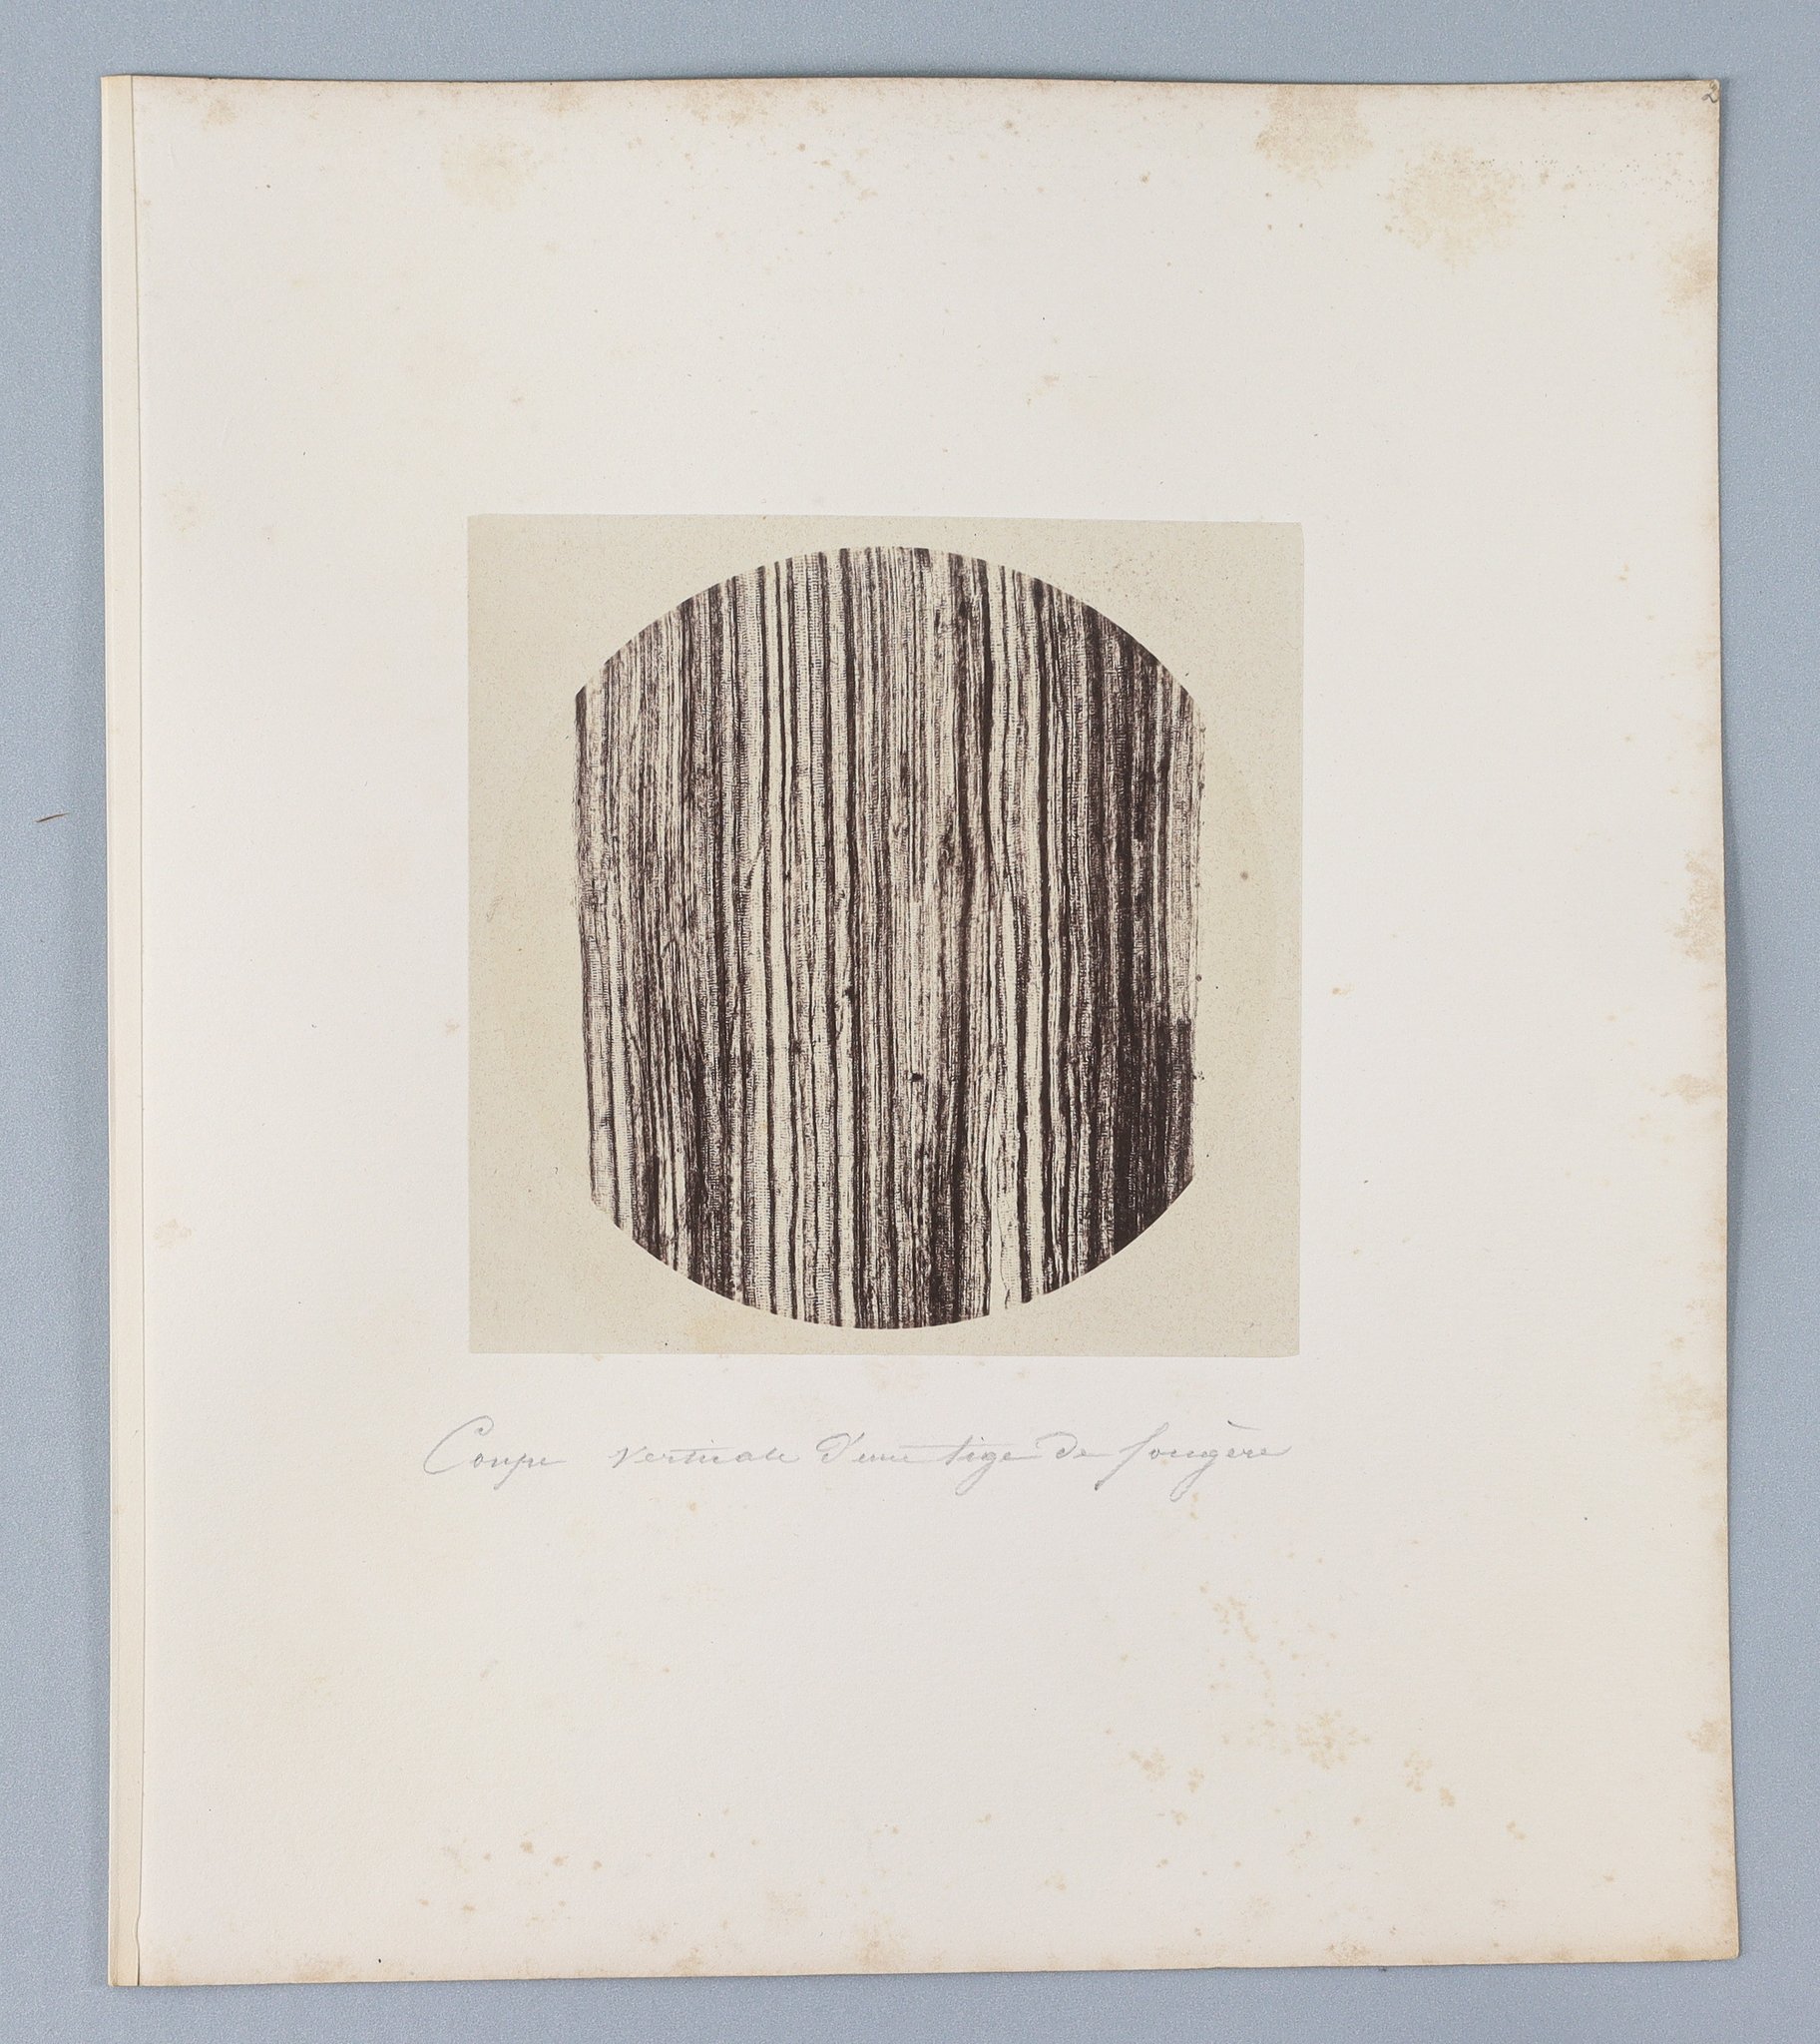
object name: photograph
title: [Untitled]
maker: auguste-adolphe bertsch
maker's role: artist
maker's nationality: french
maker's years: 1813-1871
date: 1853-1857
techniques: salted paper print